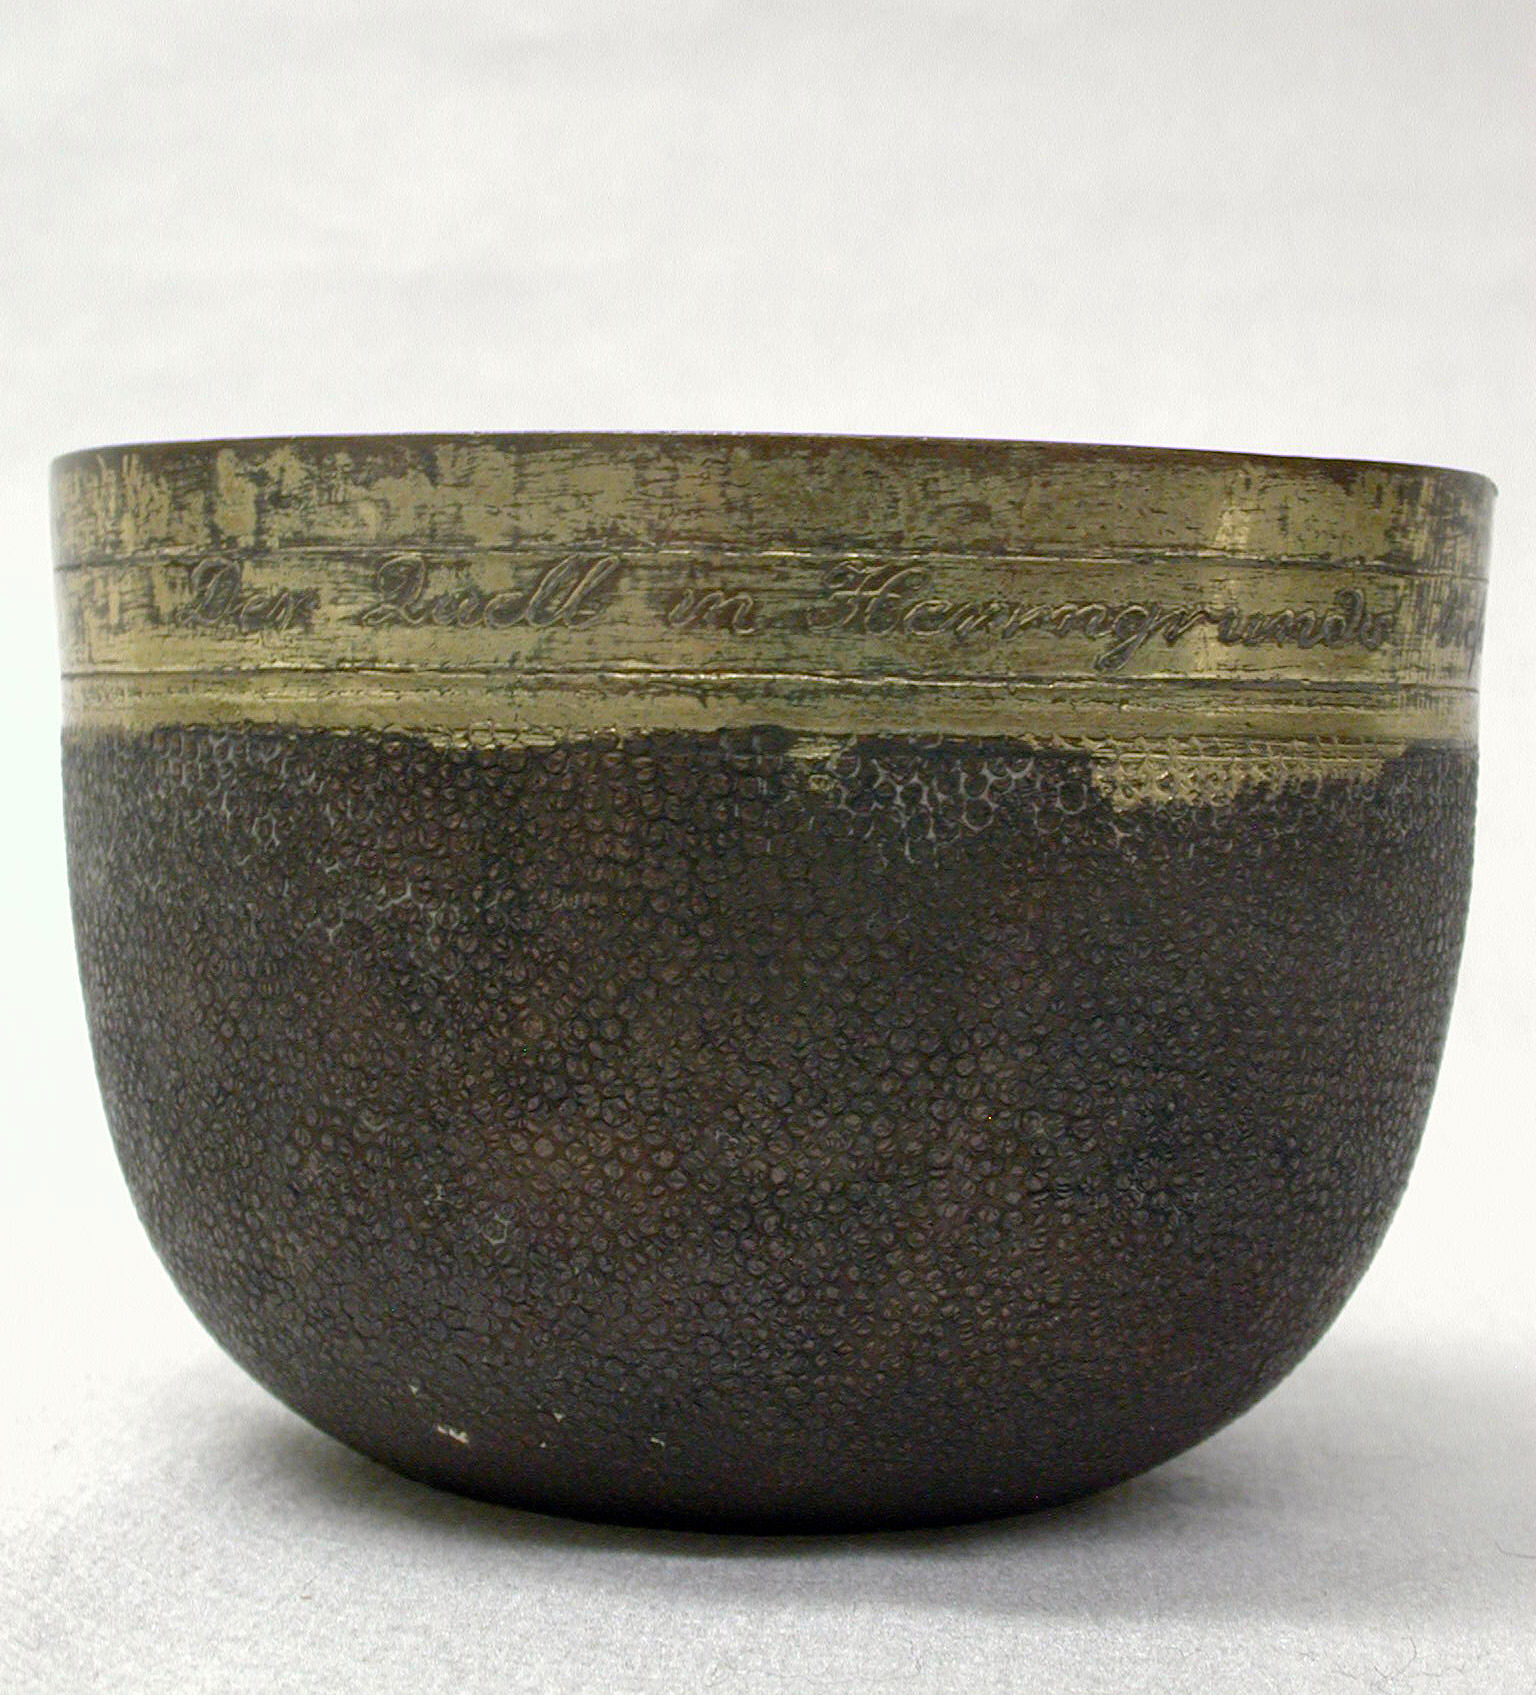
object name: cup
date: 1667-1733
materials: copper gilt